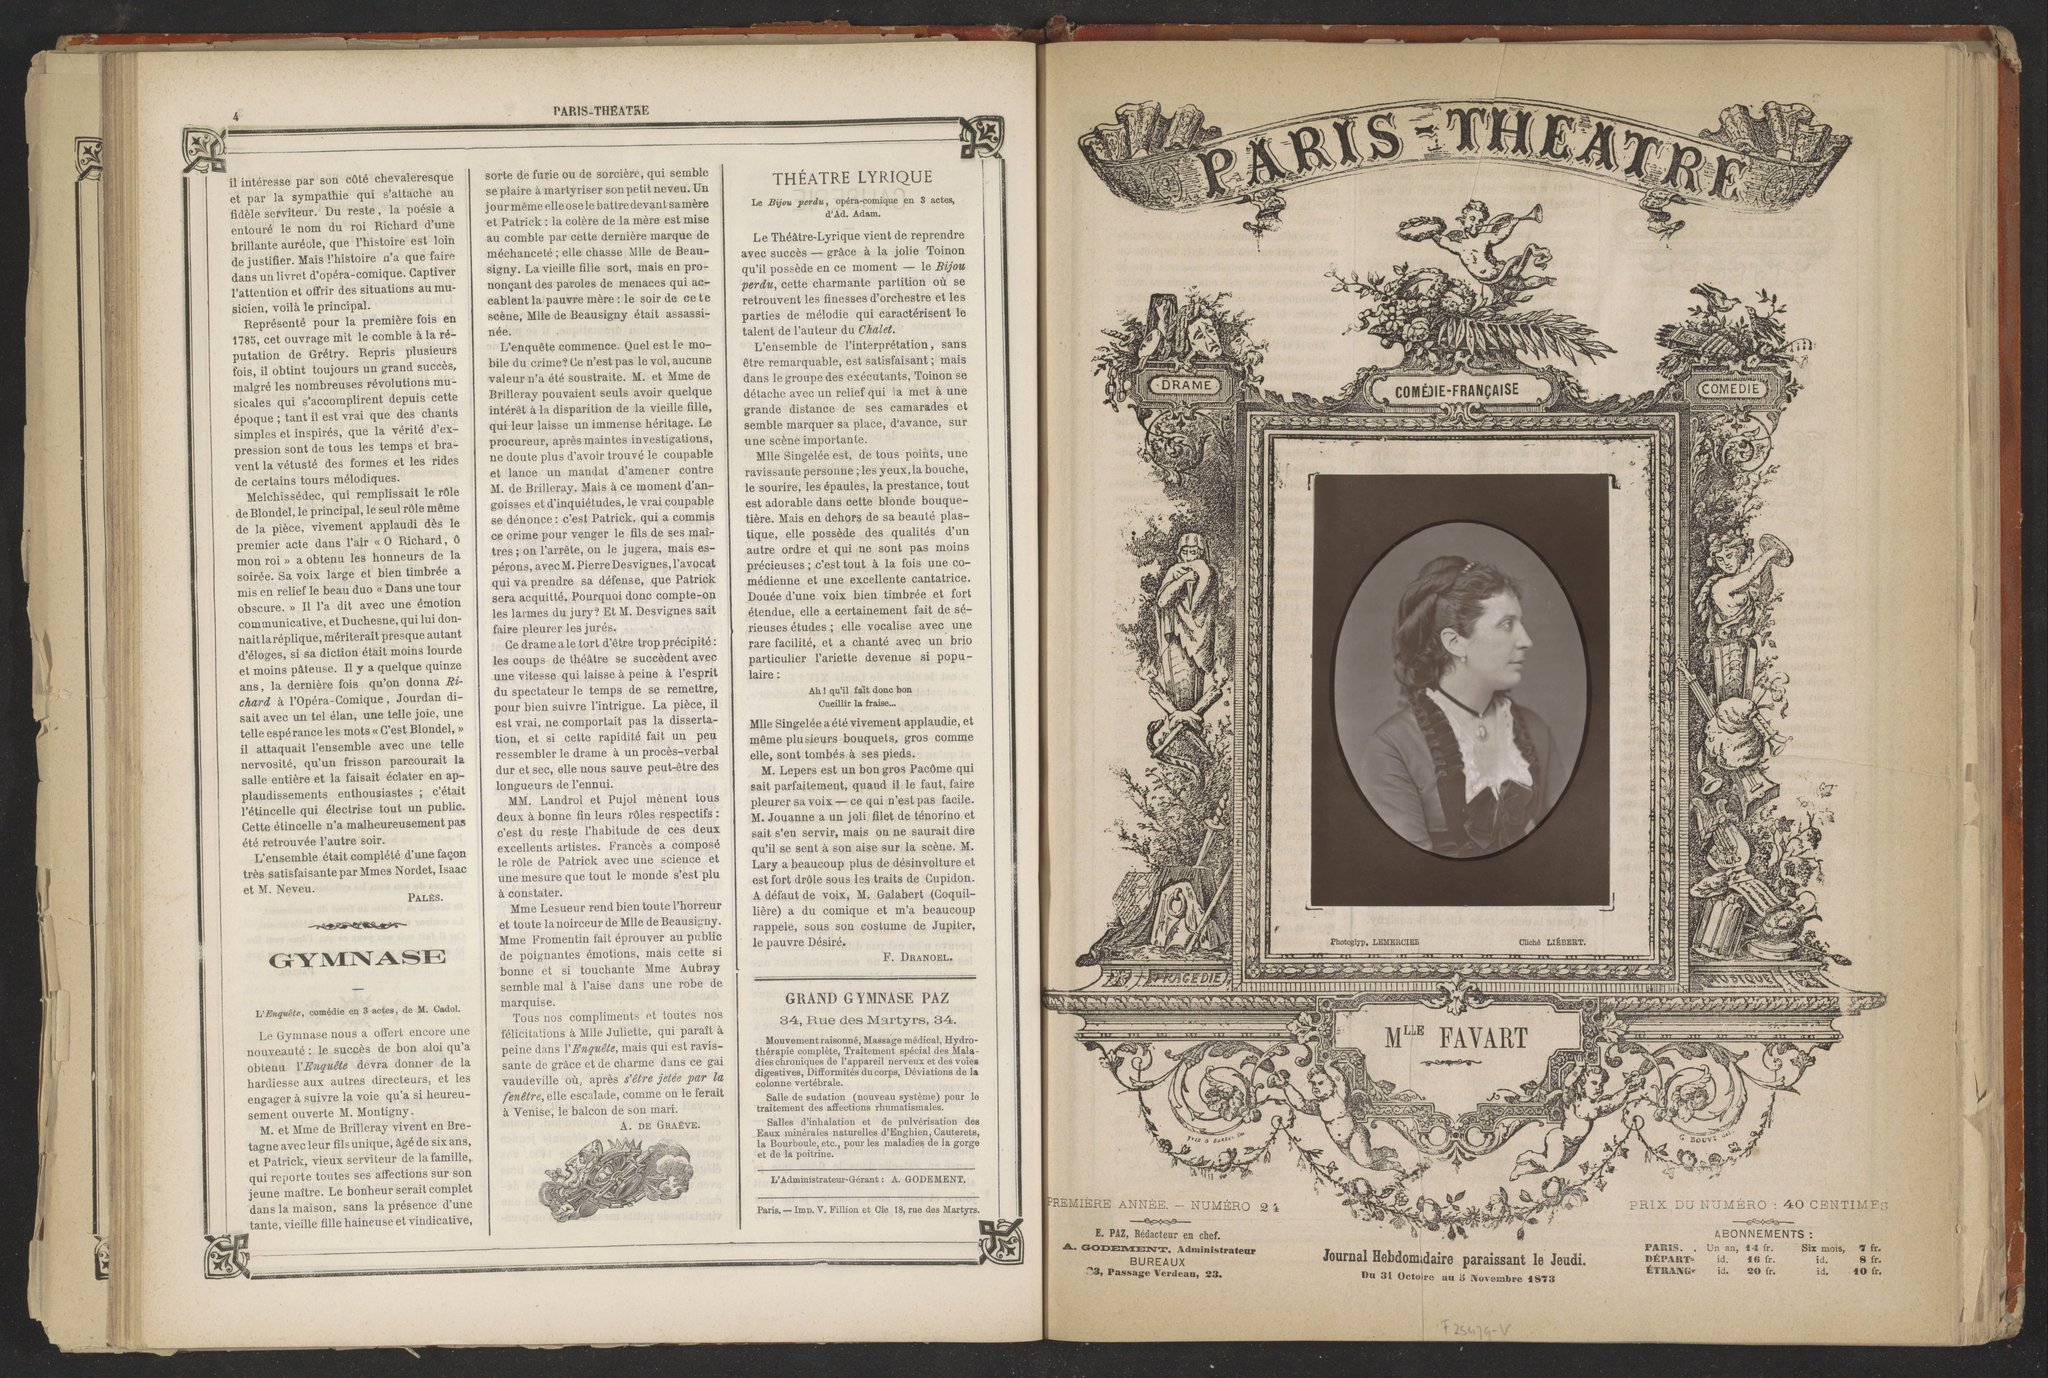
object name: photomechanical print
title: Mlle Favart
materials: paper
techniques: woodburytype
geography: france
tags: paris, portrait of actor, actress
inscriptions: number: ‘Numéro 24’, inscription: ‘Journal Hebdomadaire paraissant le Jeudi, Du 31 Octobre au 5 Novembre 1873’